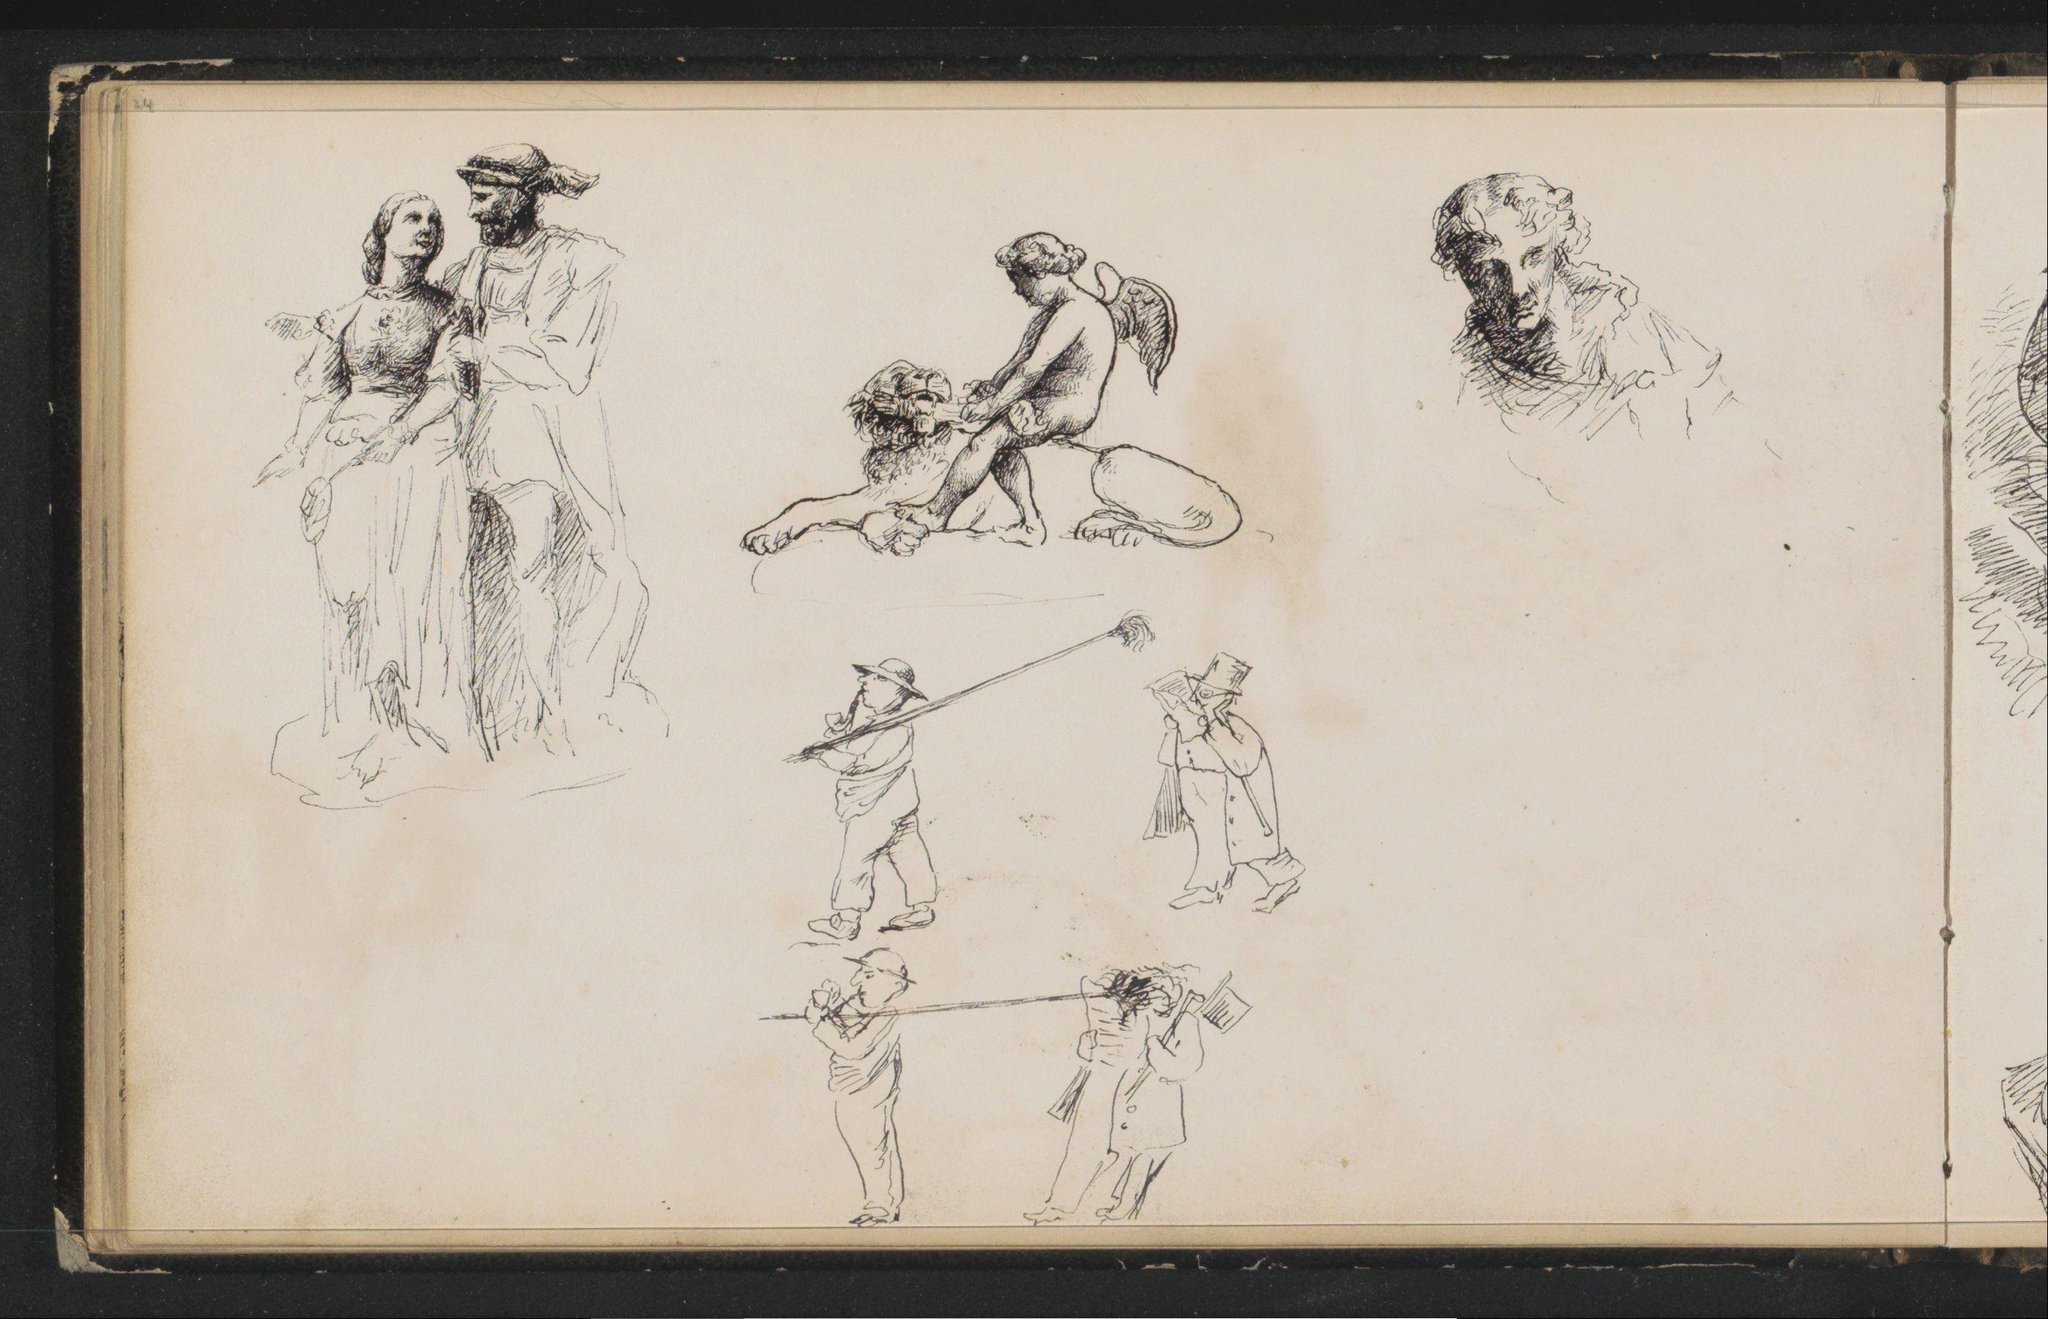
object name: sketchbook leaf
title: Studieblad, onder andere met karikaturen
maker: marius bauer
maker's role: draughtsman, print maker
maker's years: 1867-1932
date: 1812-1880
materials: paper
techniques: pen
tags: adult woman, adult man, beasts of prey, predatory animals: lion, angels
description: Tevens studies van een engel met een leeuw, een vrouwenkop en een man en vrouw. Mogelijk studies naar beeldhouwwerk of (boek)illustraties. Pagina 24 uit een schetsboek met 34 bladen.